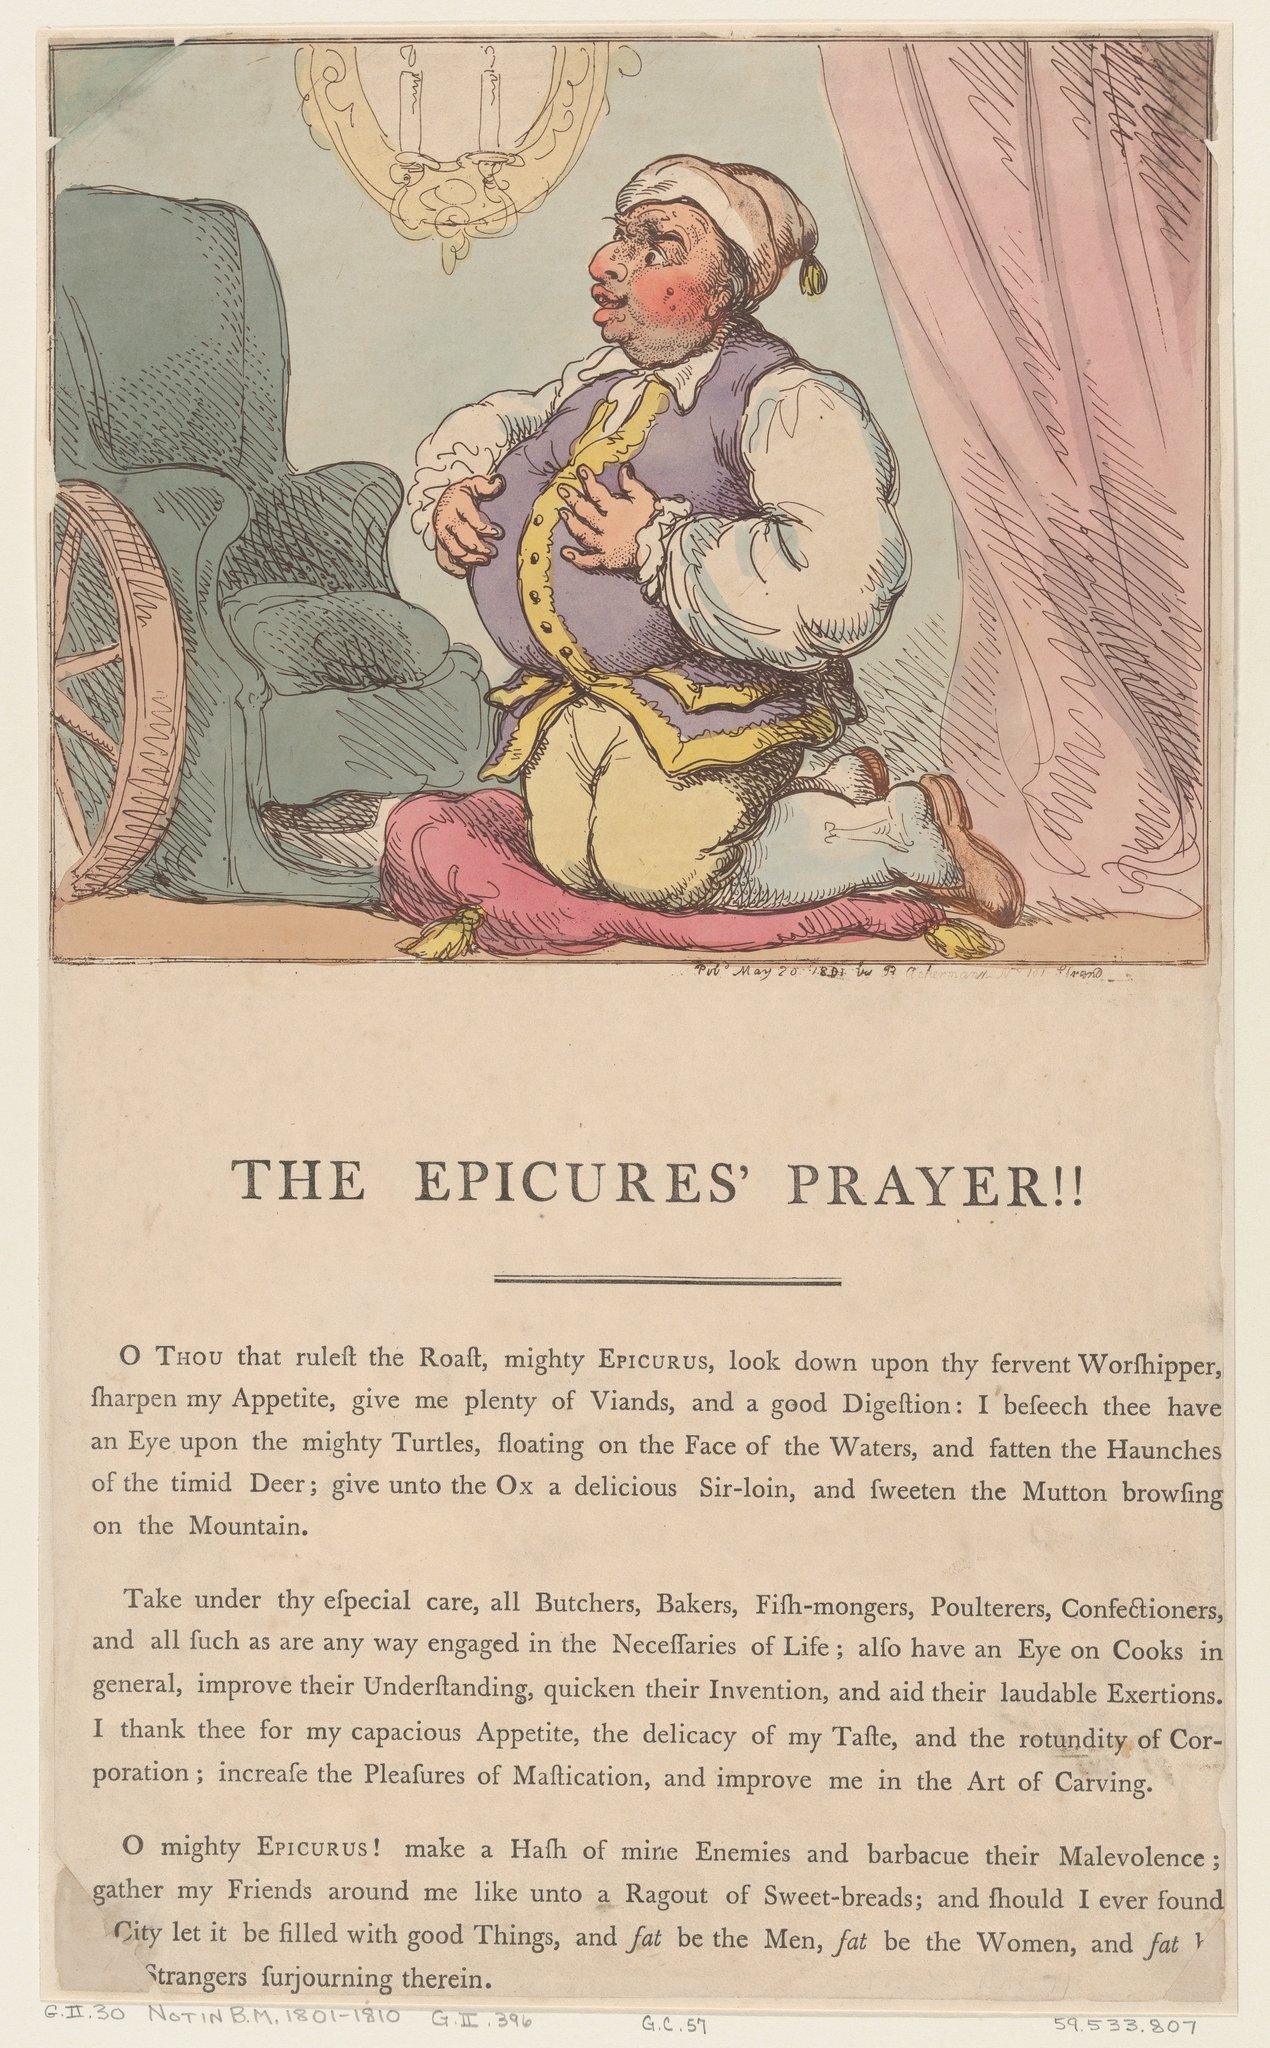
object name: print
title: The Epicure's Prayer!!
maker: thomas rowlandson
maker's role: artist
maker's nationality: british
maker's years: 1757-1827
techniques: etching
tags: men